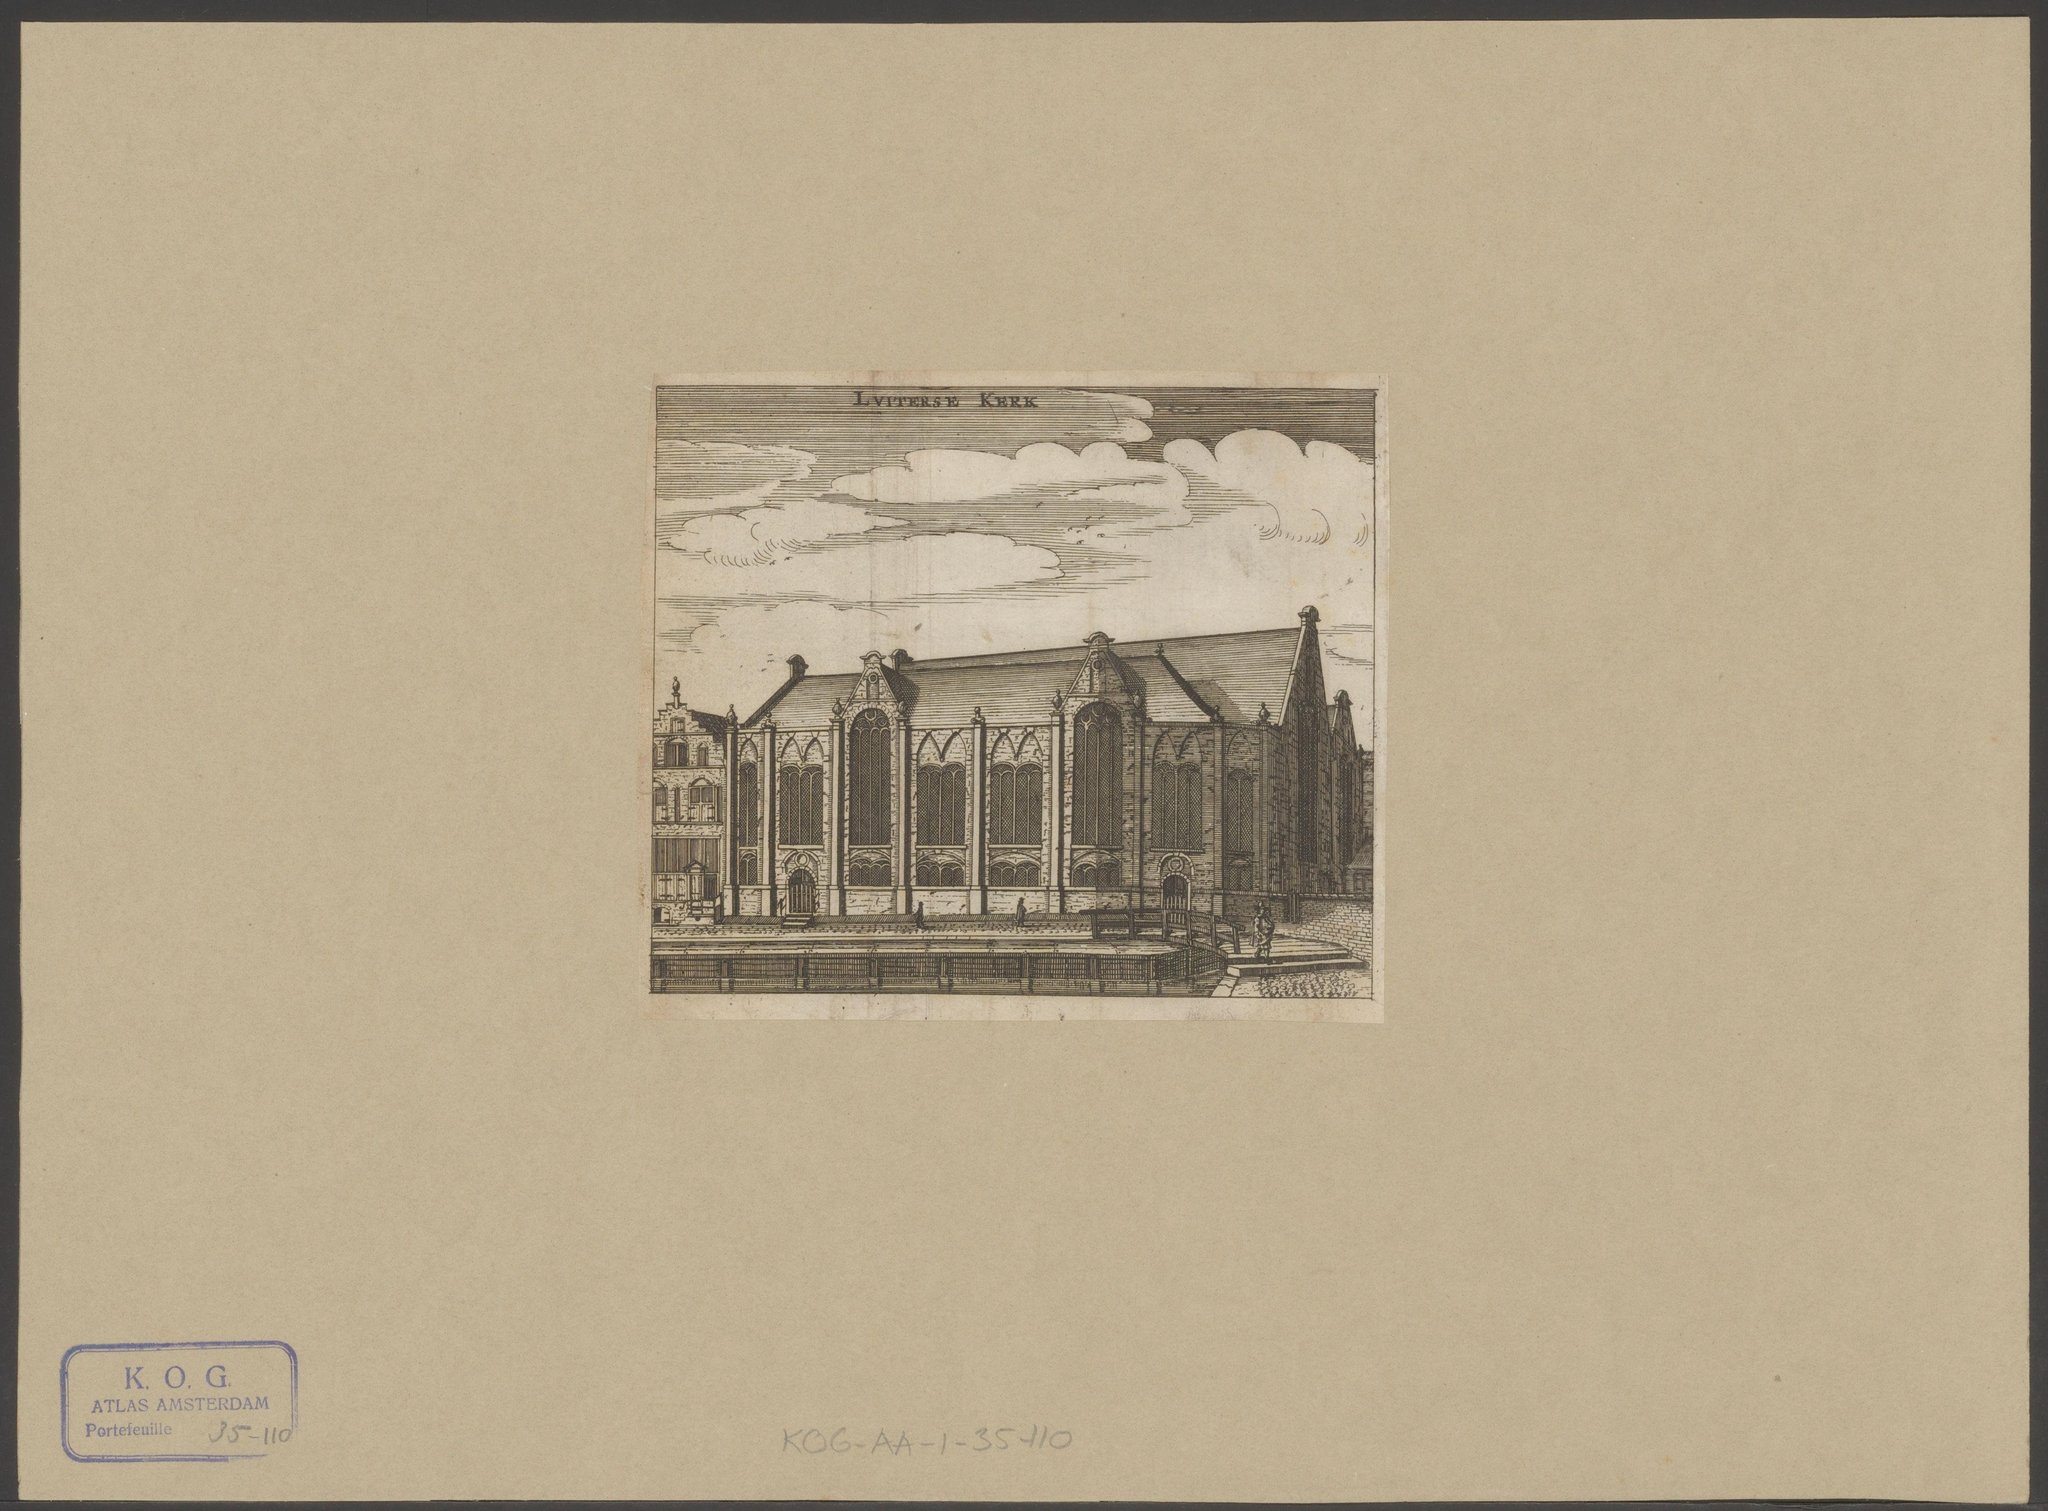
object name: print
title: Gezicht op de Oude Lutherse Kerk te Amsterdam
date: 1665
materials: paper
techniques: engraving, etching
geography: amsterdam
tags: sluice, weir, protestant churches and denominations, protestant churches and denominations (lutherans), canals, waters (in city)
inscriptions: collector's mark: ‘35-110’ Lugt 1641b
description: Huidige staat uit: Fockens, Melchior. Beschrijving Der wijdt-vermaarde Koop-stadt Amstelredam, Van haar eerste beginselen, zedert den Jare 1203. oude Voorrechten, verscheyde Vergrootingenoude Voor-rechten, en verscheyde Vergrootingen (…). 3de druk. Amsterdam: Marcus Willemsz. Doornick, 1664. En in: Zesen, Philipp von. Beschrybung der Weidtberuhmde Kauf-Stadt Amstelredam / Beschreibung der Stadt Amsterdam darinnen von derselben ersten ursprunge bis auf gegenwartigen zustand (…). Amsterdam: Marcus Willemsz. Doornick, 1664. Latere staat van prent (met toevoeging van Franse titel) gebruikt in: Domselaer, Tobias en Isaac Commelin. Beschryvinge van Amsterdam: haar eerste oorspronk uyt den huyze der heeren van Aemstel en Aemstellant (…). 6 dln. Amsterdam: Marcus Willemsz van Doornick, 1665. Derde bekende staat (rechtsboven genummerd: 19) ook gebruikt in verschillende latere zeventiende- en achttiende-eeuwse publicaties.